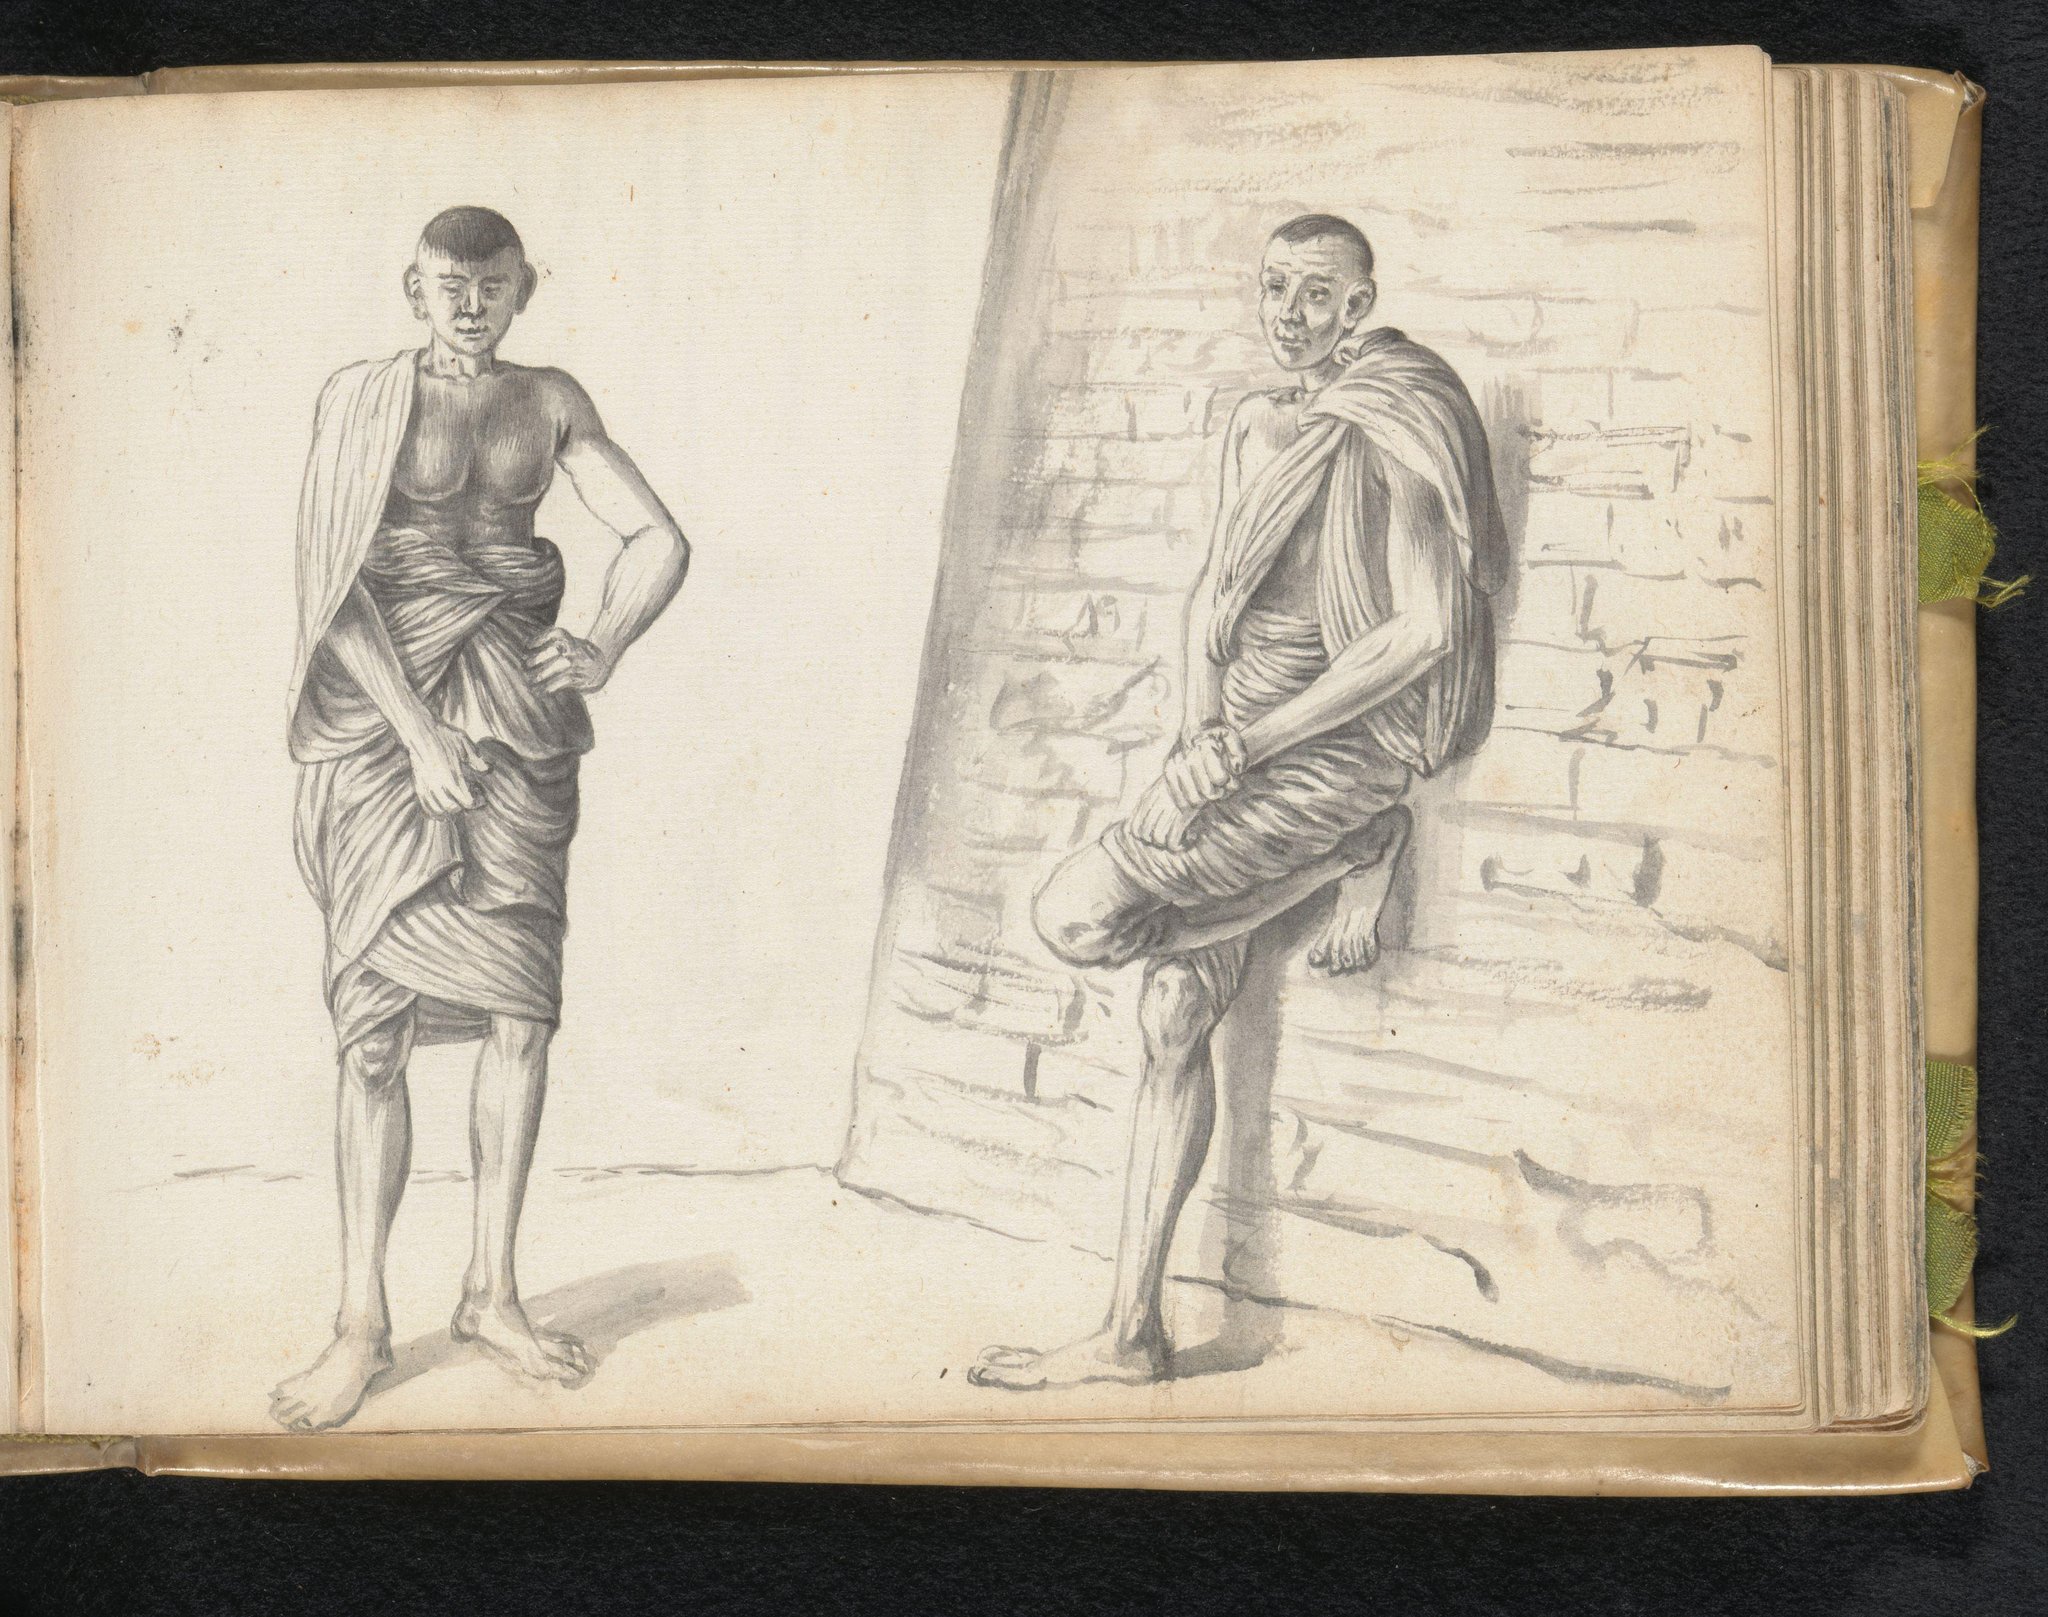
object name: sketchbook leaf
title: Two labourers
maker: esaias boursse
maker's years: 1631-1672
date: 1662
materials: ink, paper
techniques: brush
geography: sri lanka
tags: 41d232(...) skirt (lungi), head-gear (with name), working class, labourers, asiatic races and peoples: indians, sri lanka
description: Buiten bij een schuin naar achter lopende muur van klipsteen, misschien de hoek van een vestingmuur, staan twee jonge mannen. De linker man draagt een dubbelgeslagen heupkleed (veshti, lungi) tot op de knieën; een omslagdoek (chadar) hangt over de rechterschouder en is ook om het middel geslagen en in de taille vastgestopt. De man rechts leunt met zijn rug tegen de schuine muur. Zijn linkerbeen heeft hij opgetrokken met de voet tegen de muur en de knie naar voren. Hij draagt een heupkleed (veshti, lungi) tot op de knie, en om de linkerschouder een doek (chadar). Beide mannen zijn afkomstig van Zuid-India en in Colombo te werk gesteld bij de wederopbouw. Blad 55 uit een schetsboek met 117 bladen.